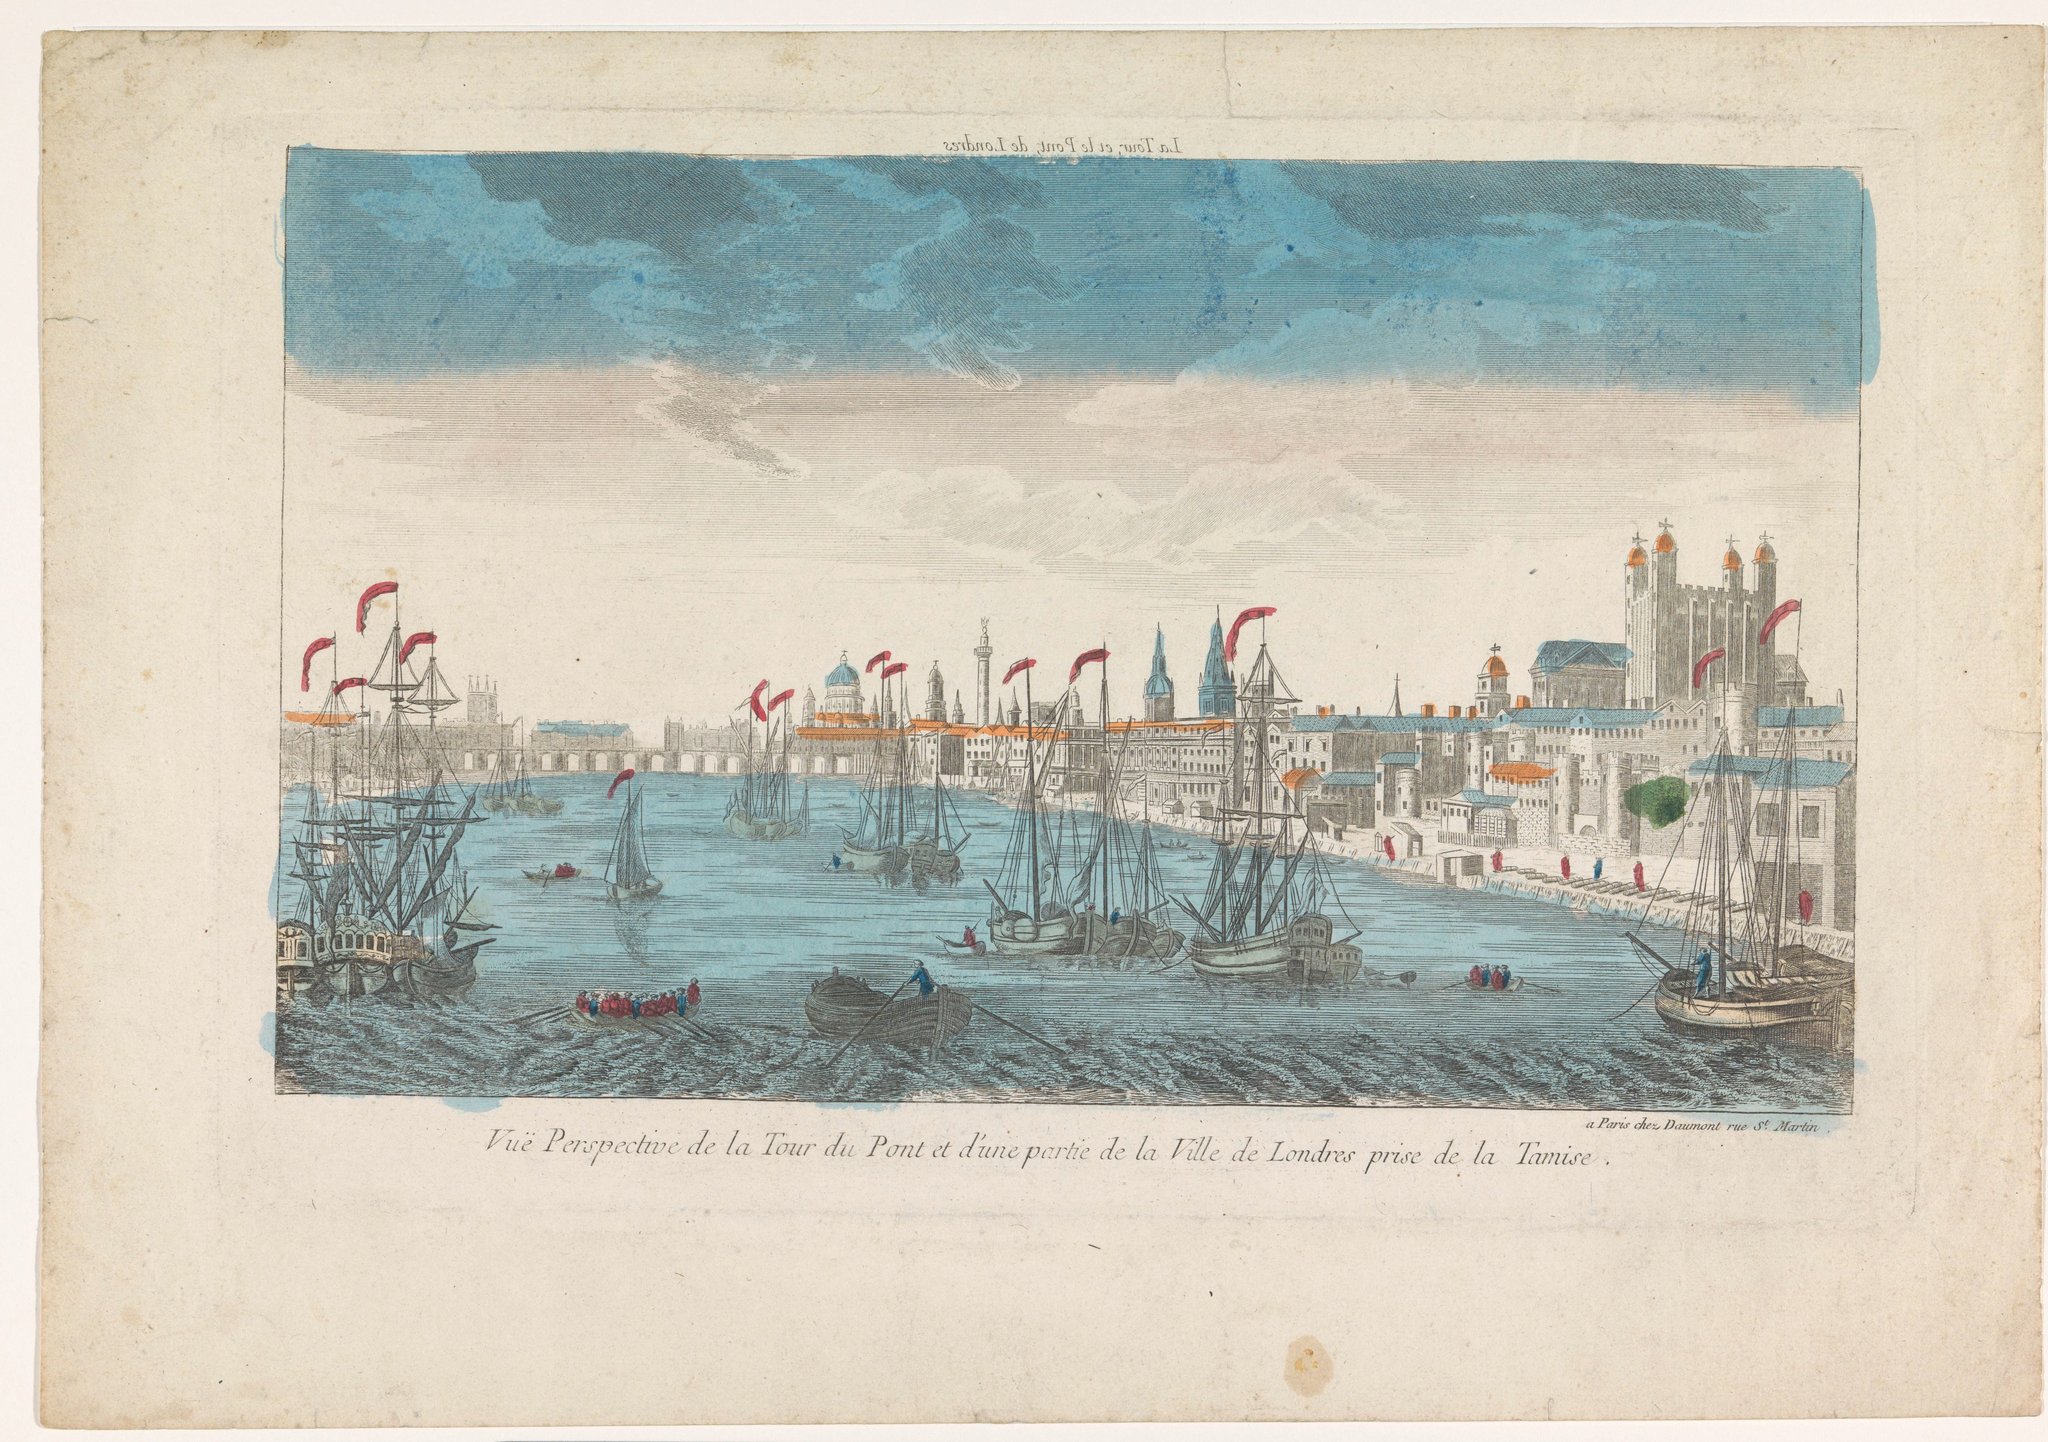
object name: opticaprent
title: La Tour, et le Pont de Londres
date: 1745-1775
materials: paper, watercolor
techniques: brush, etching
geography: france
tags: sailing-ship, sailing-boat, rowing-boat, canoe, etc., city-view in general; 'veduta' (+ city(-scape) with figures, staffage), thames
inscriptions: watermark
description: Rechts de Tower of London en op de achtergrond Saint Paul's Cathedral.